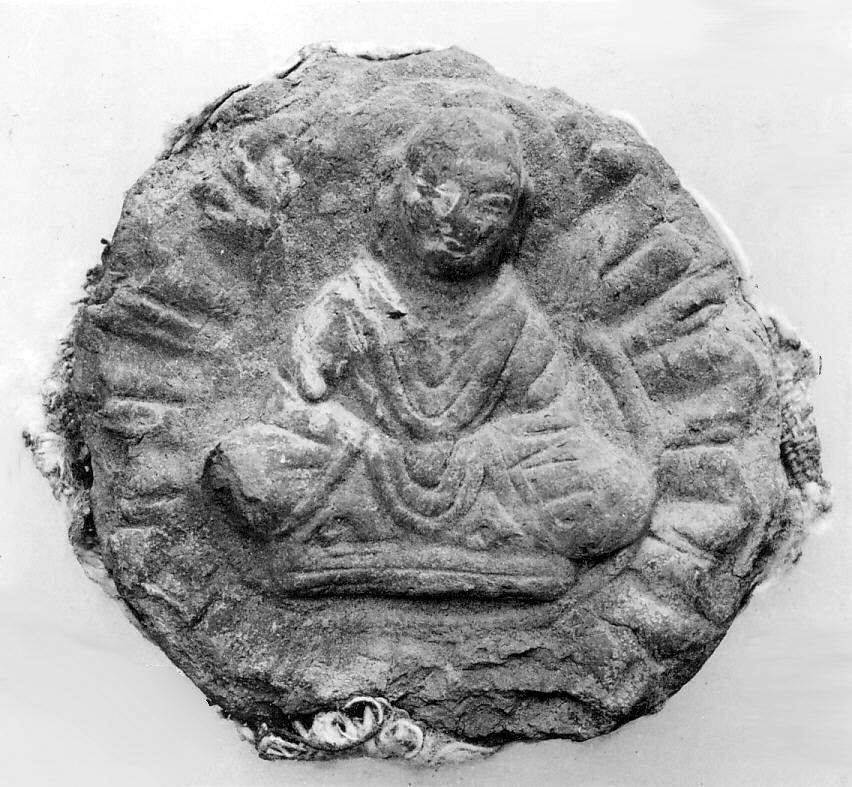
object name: relief fragment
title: Fragment of a Relief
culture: central asian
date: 201-700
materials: clay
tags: human figures